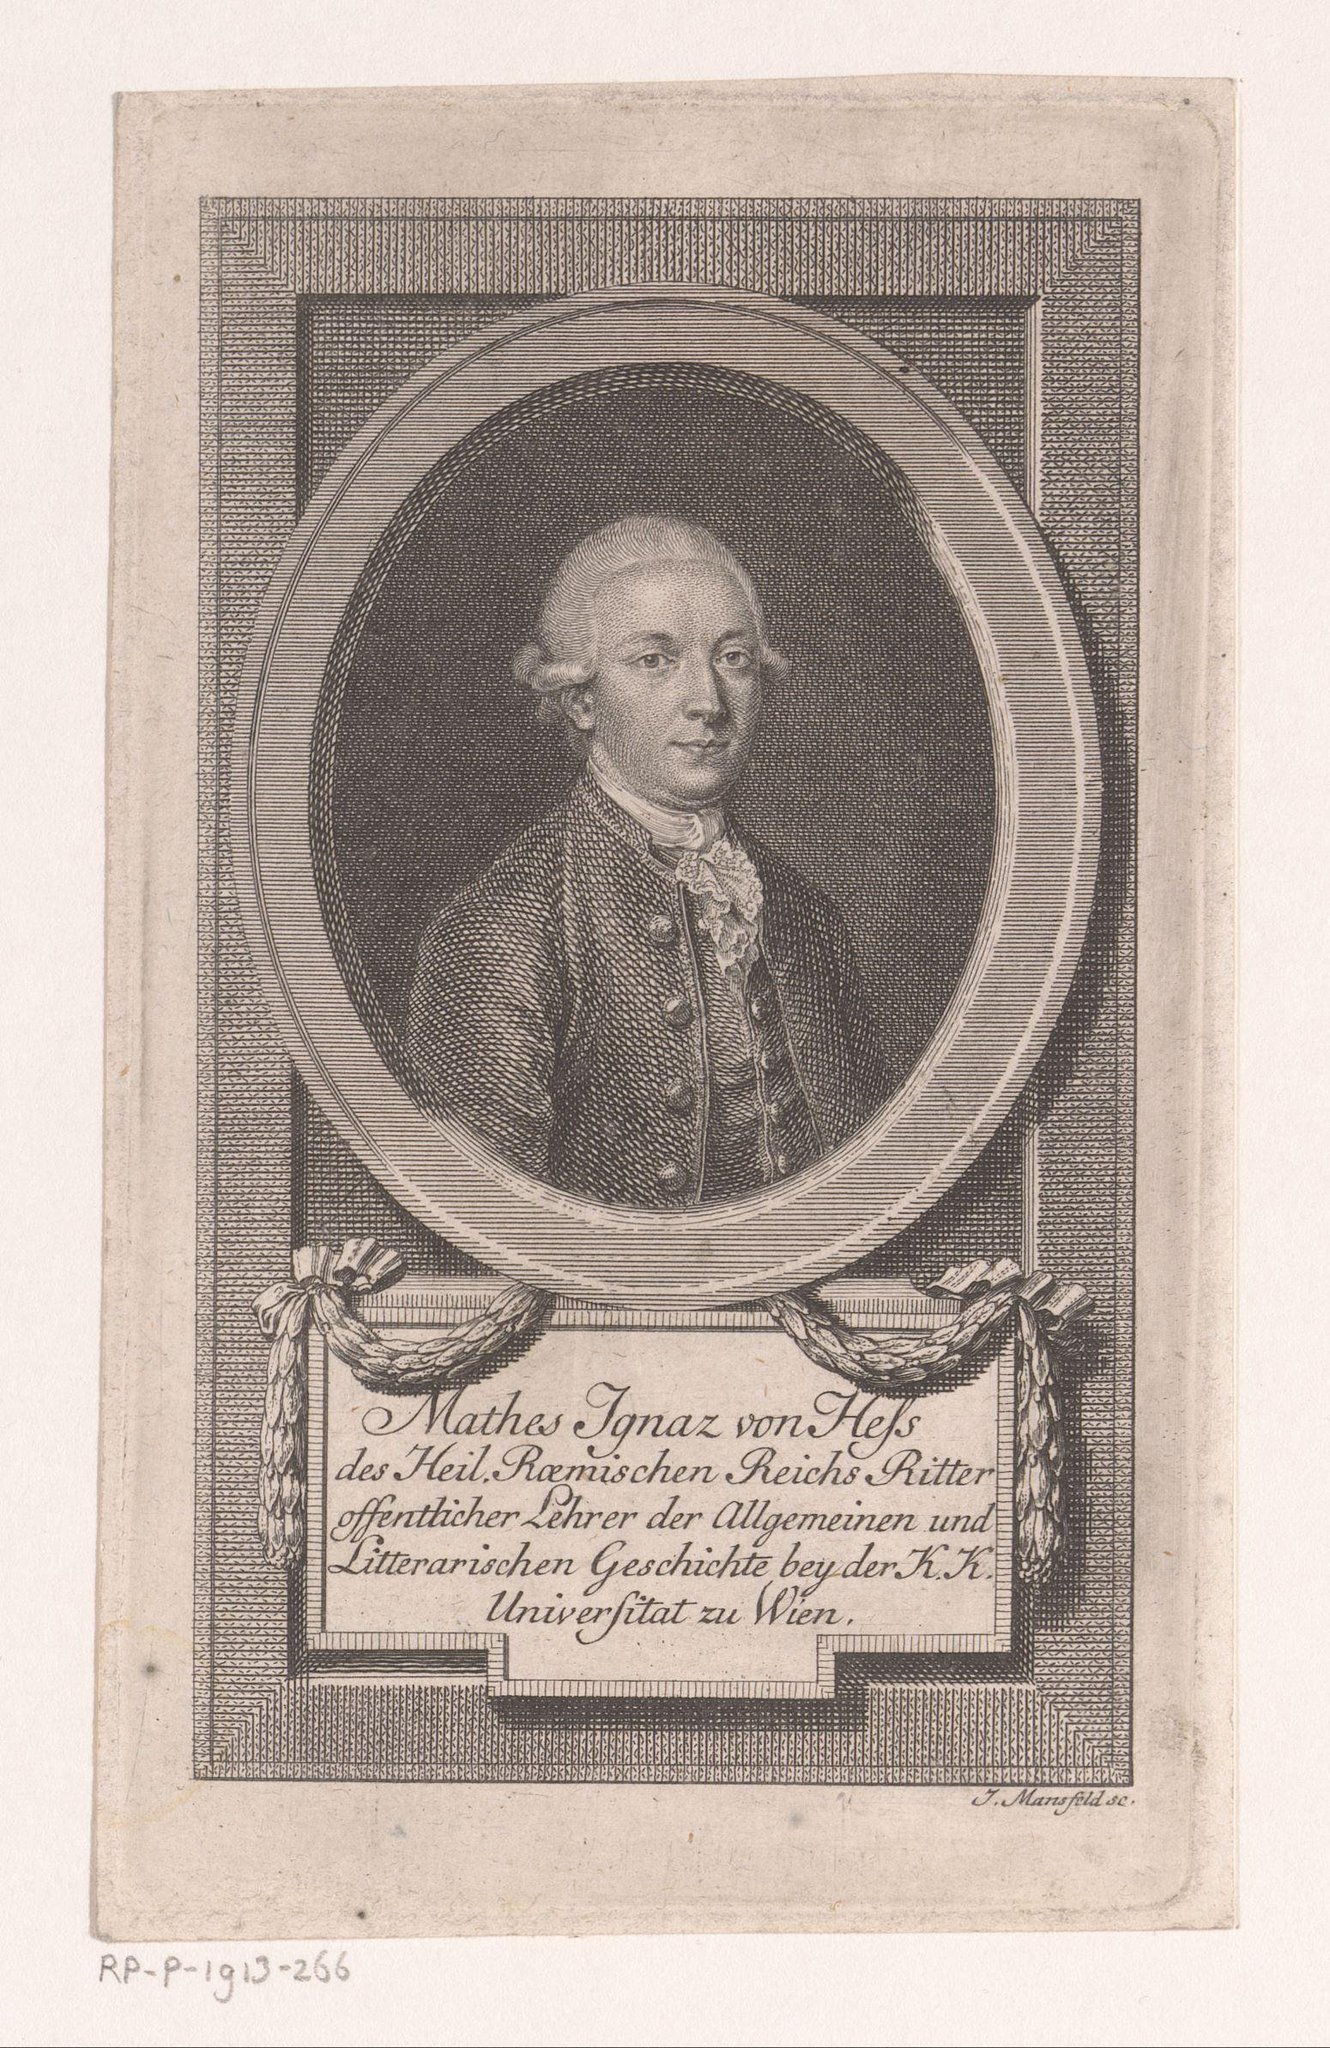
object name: print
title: Portret van Matthias Ignaz von Hess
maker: johann ernst mansfeld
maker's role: print maker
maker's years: 1739-1796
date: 1749-1796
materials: paper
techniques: engraving, etching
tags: historical persons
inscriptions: collector's mark: Lugt 2228